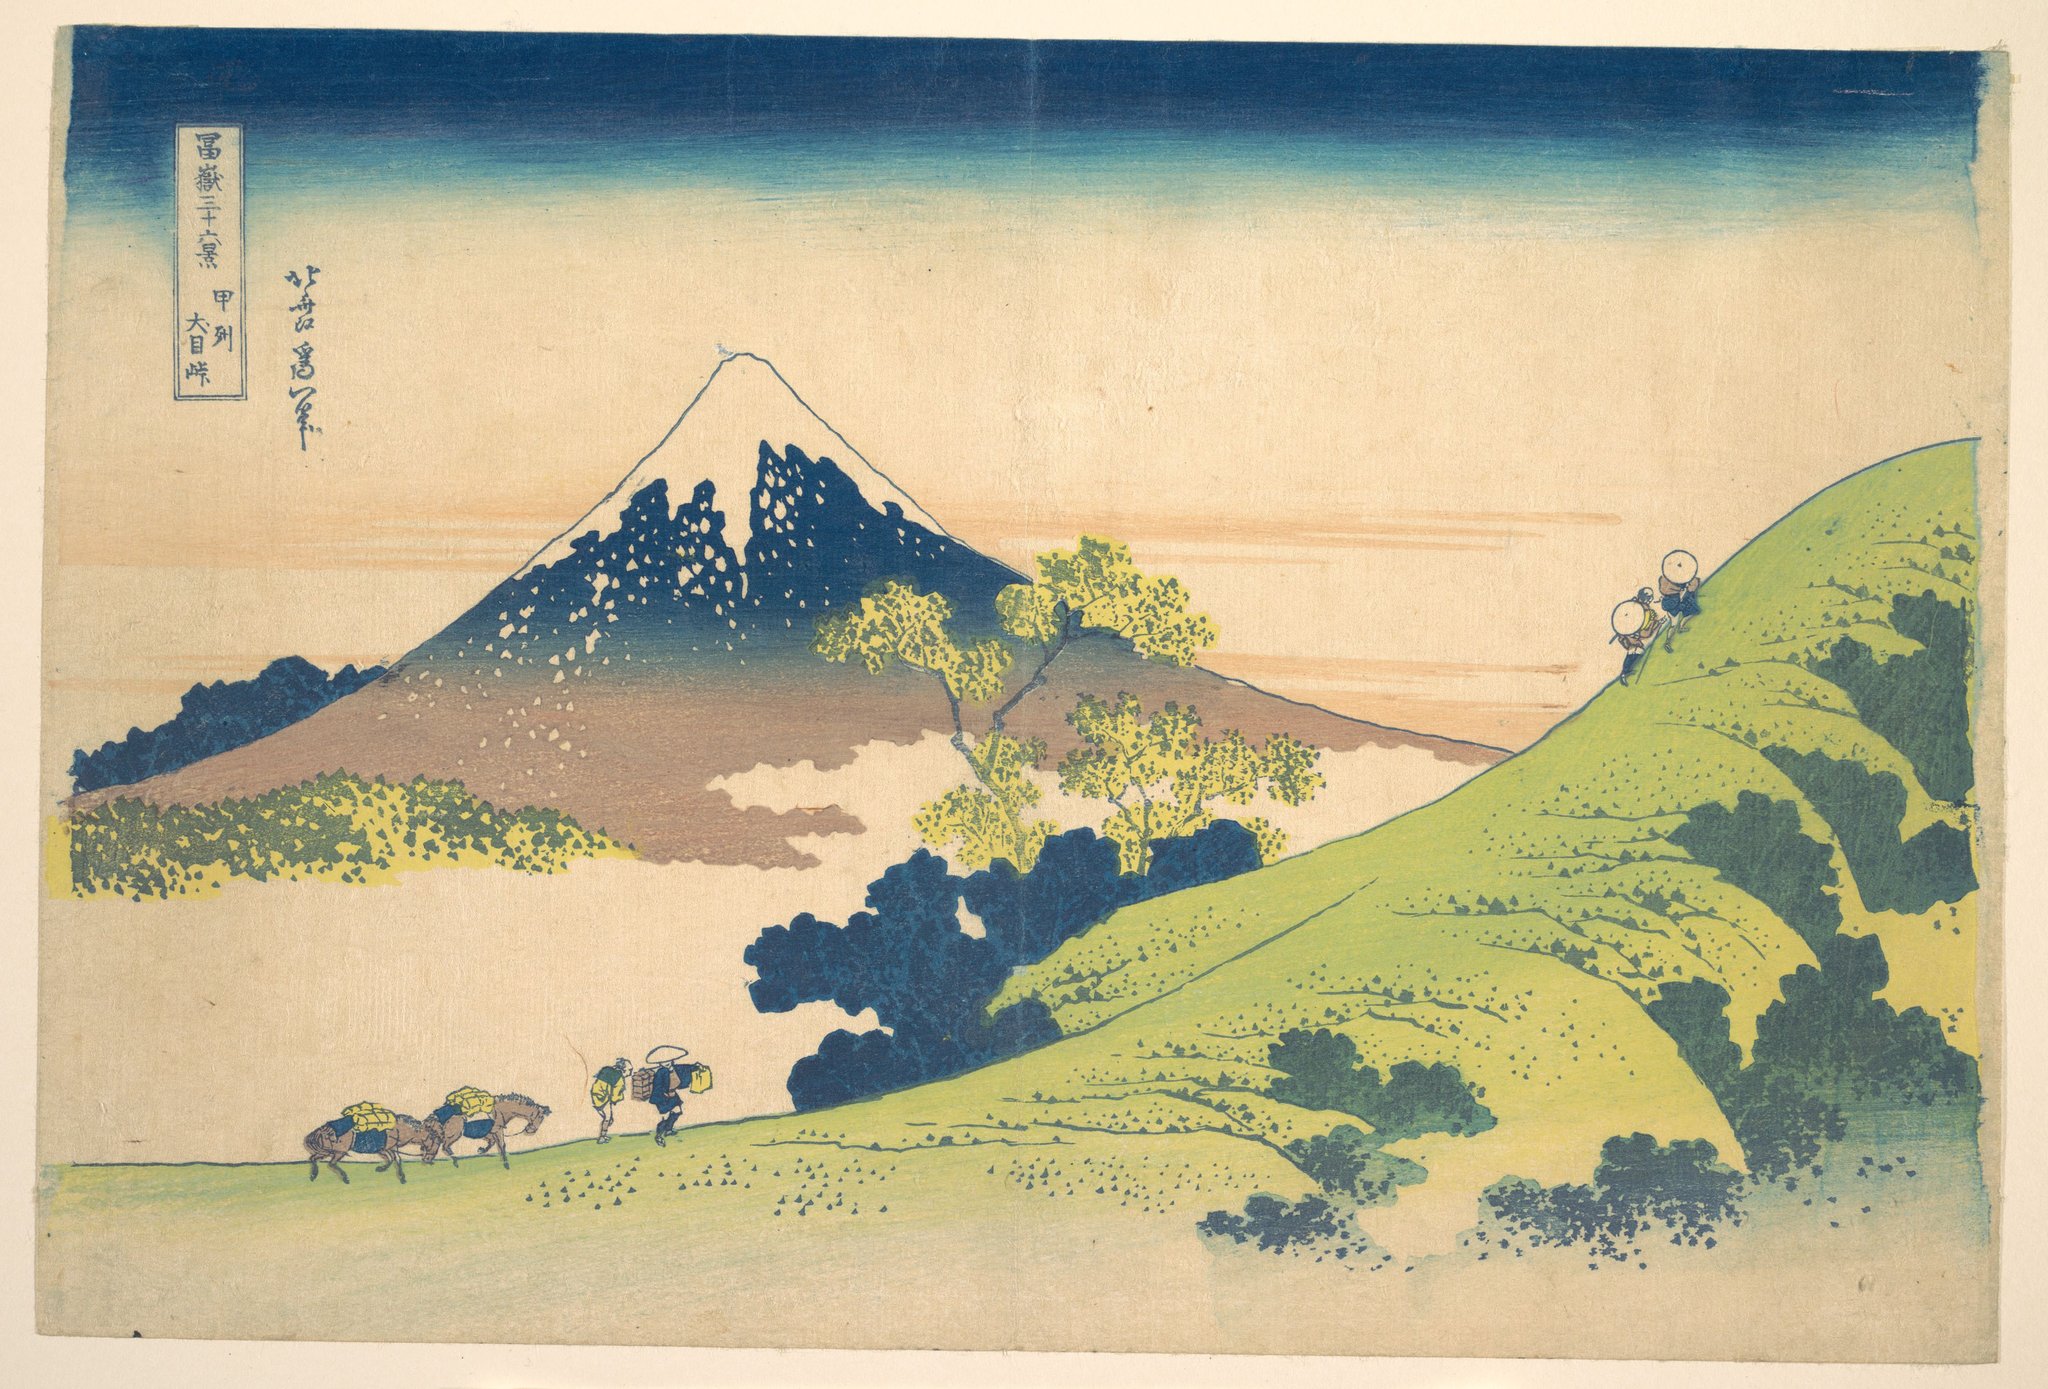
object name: woodblock print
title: The Inume Pass in Kai Province (Kōshū Inume tōge), from the series Thirty-six Views of Mount Fuji (Fugaku sanjūrokkei)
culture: japanese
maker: katsushika hokusai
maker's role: artist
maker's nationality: japanese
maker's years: 1760-1849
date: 1830-1832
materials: ink, paper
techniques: woodblock print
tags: human figures,horses,volcanoes,trees